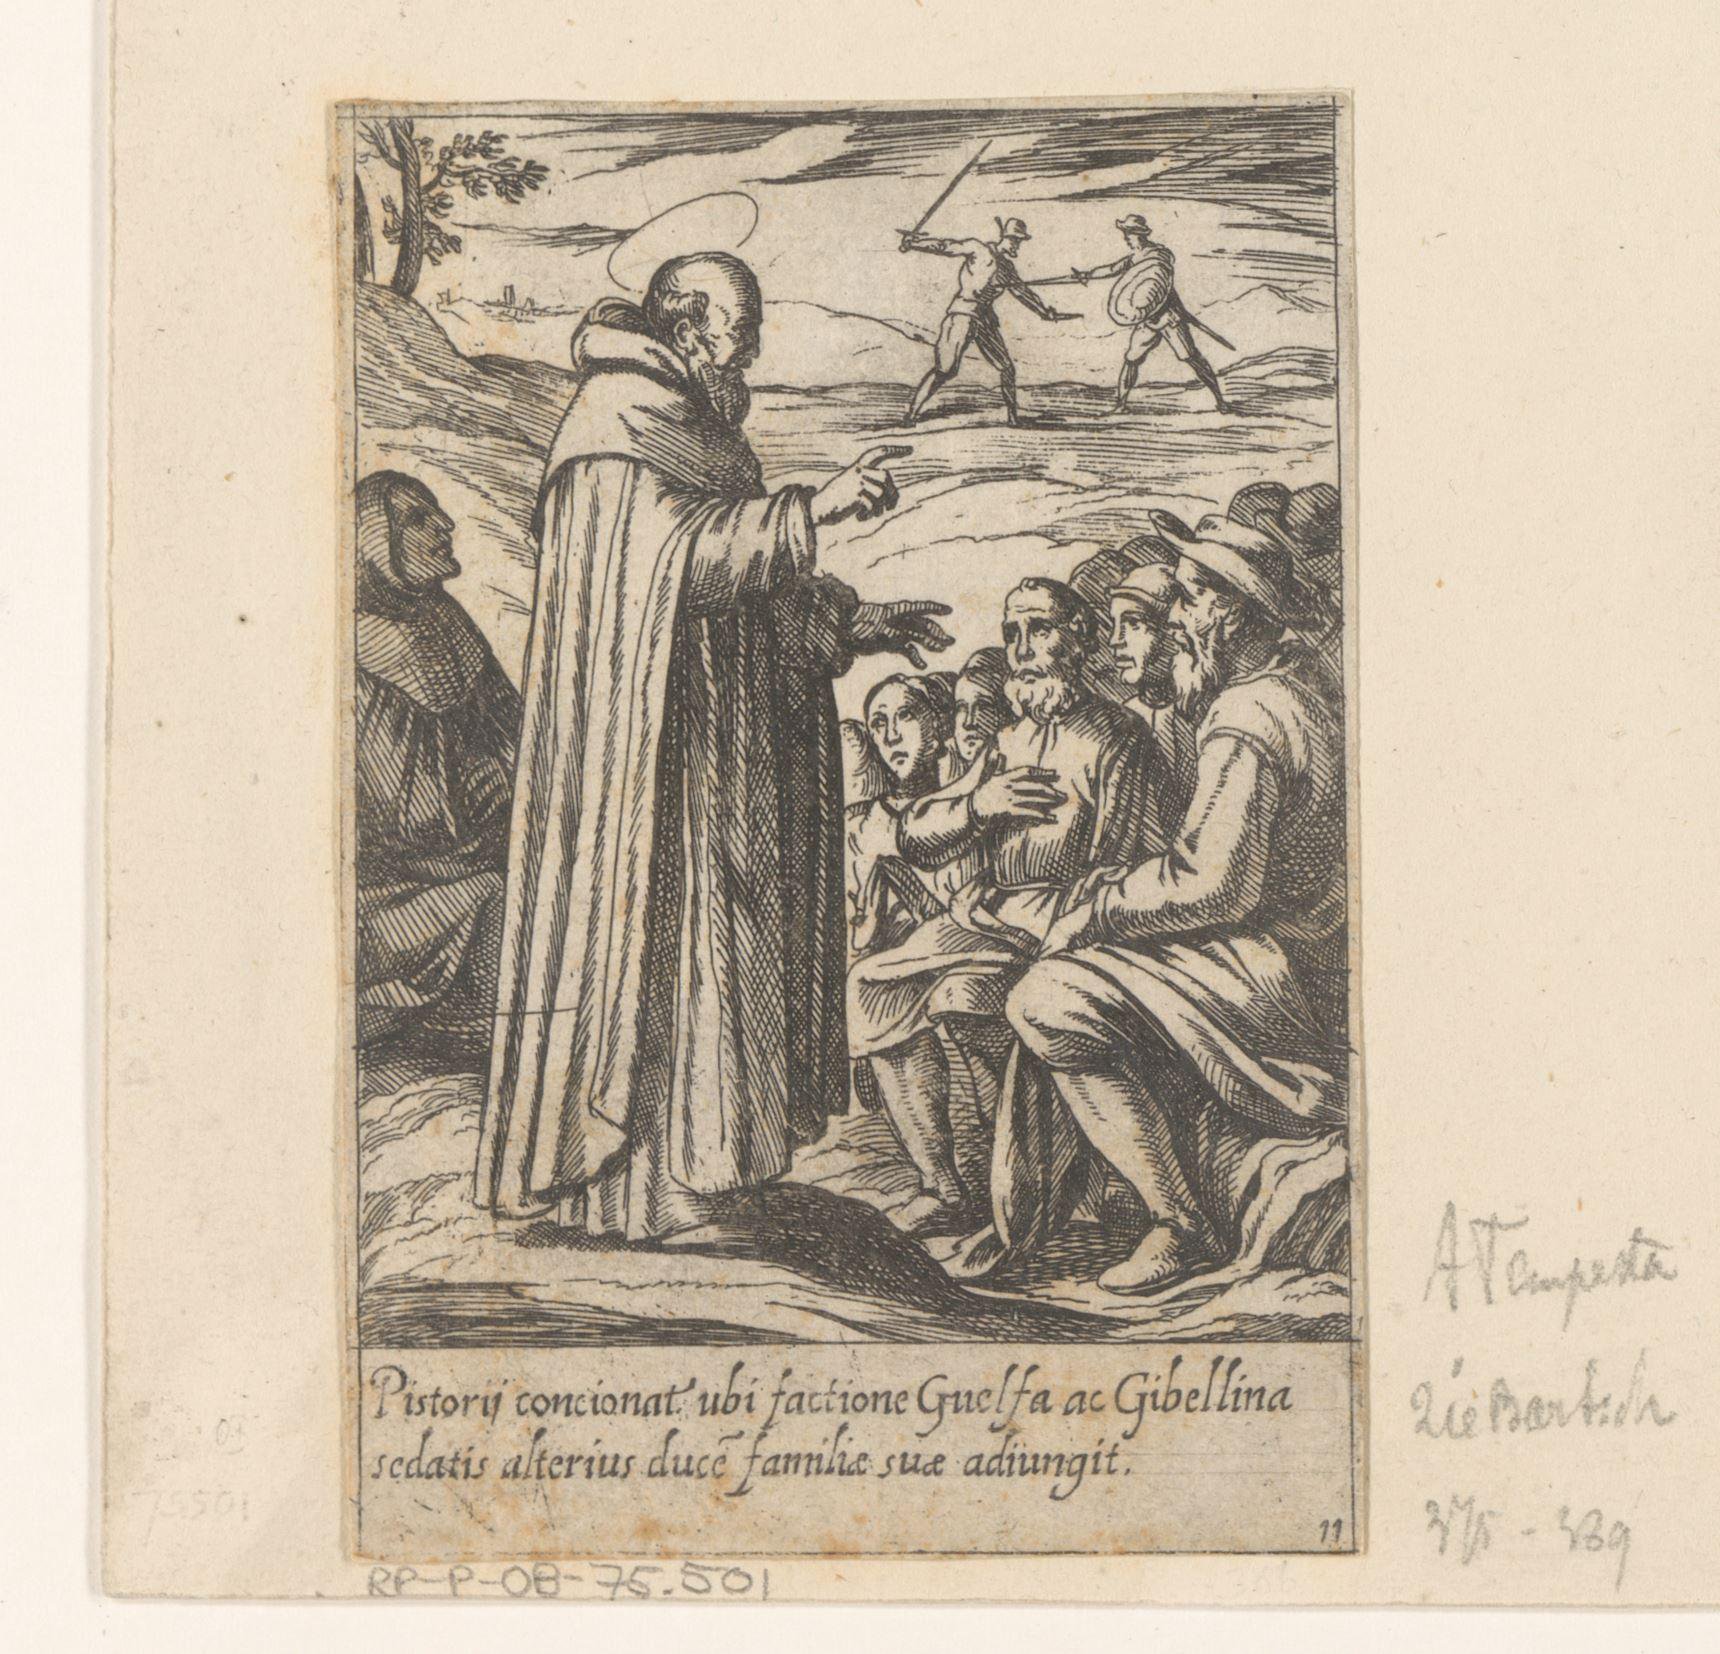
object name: print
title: Vita B. Philippi Benicii Florent. ord. servor B. Mariae virginis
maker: antonio tempesta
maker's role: draughtsman, painter, print maker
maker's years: 1555-1630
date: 1591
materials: paper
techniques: etching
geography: vatican city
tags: clergyman, prior general of the order of the servites, philip benizzi of florence; possible attributes: book, cross, lily, tiara at his feet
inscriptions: collector's mark: Lugt 240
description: De heilige Philippus sticht vrede tussen de Guelfen en Ghibellijnen. Op de achtergrond twee vechtende soldaten. Tekst in het Latijn in ondermarge. Genummerd rechtsonder: 11.